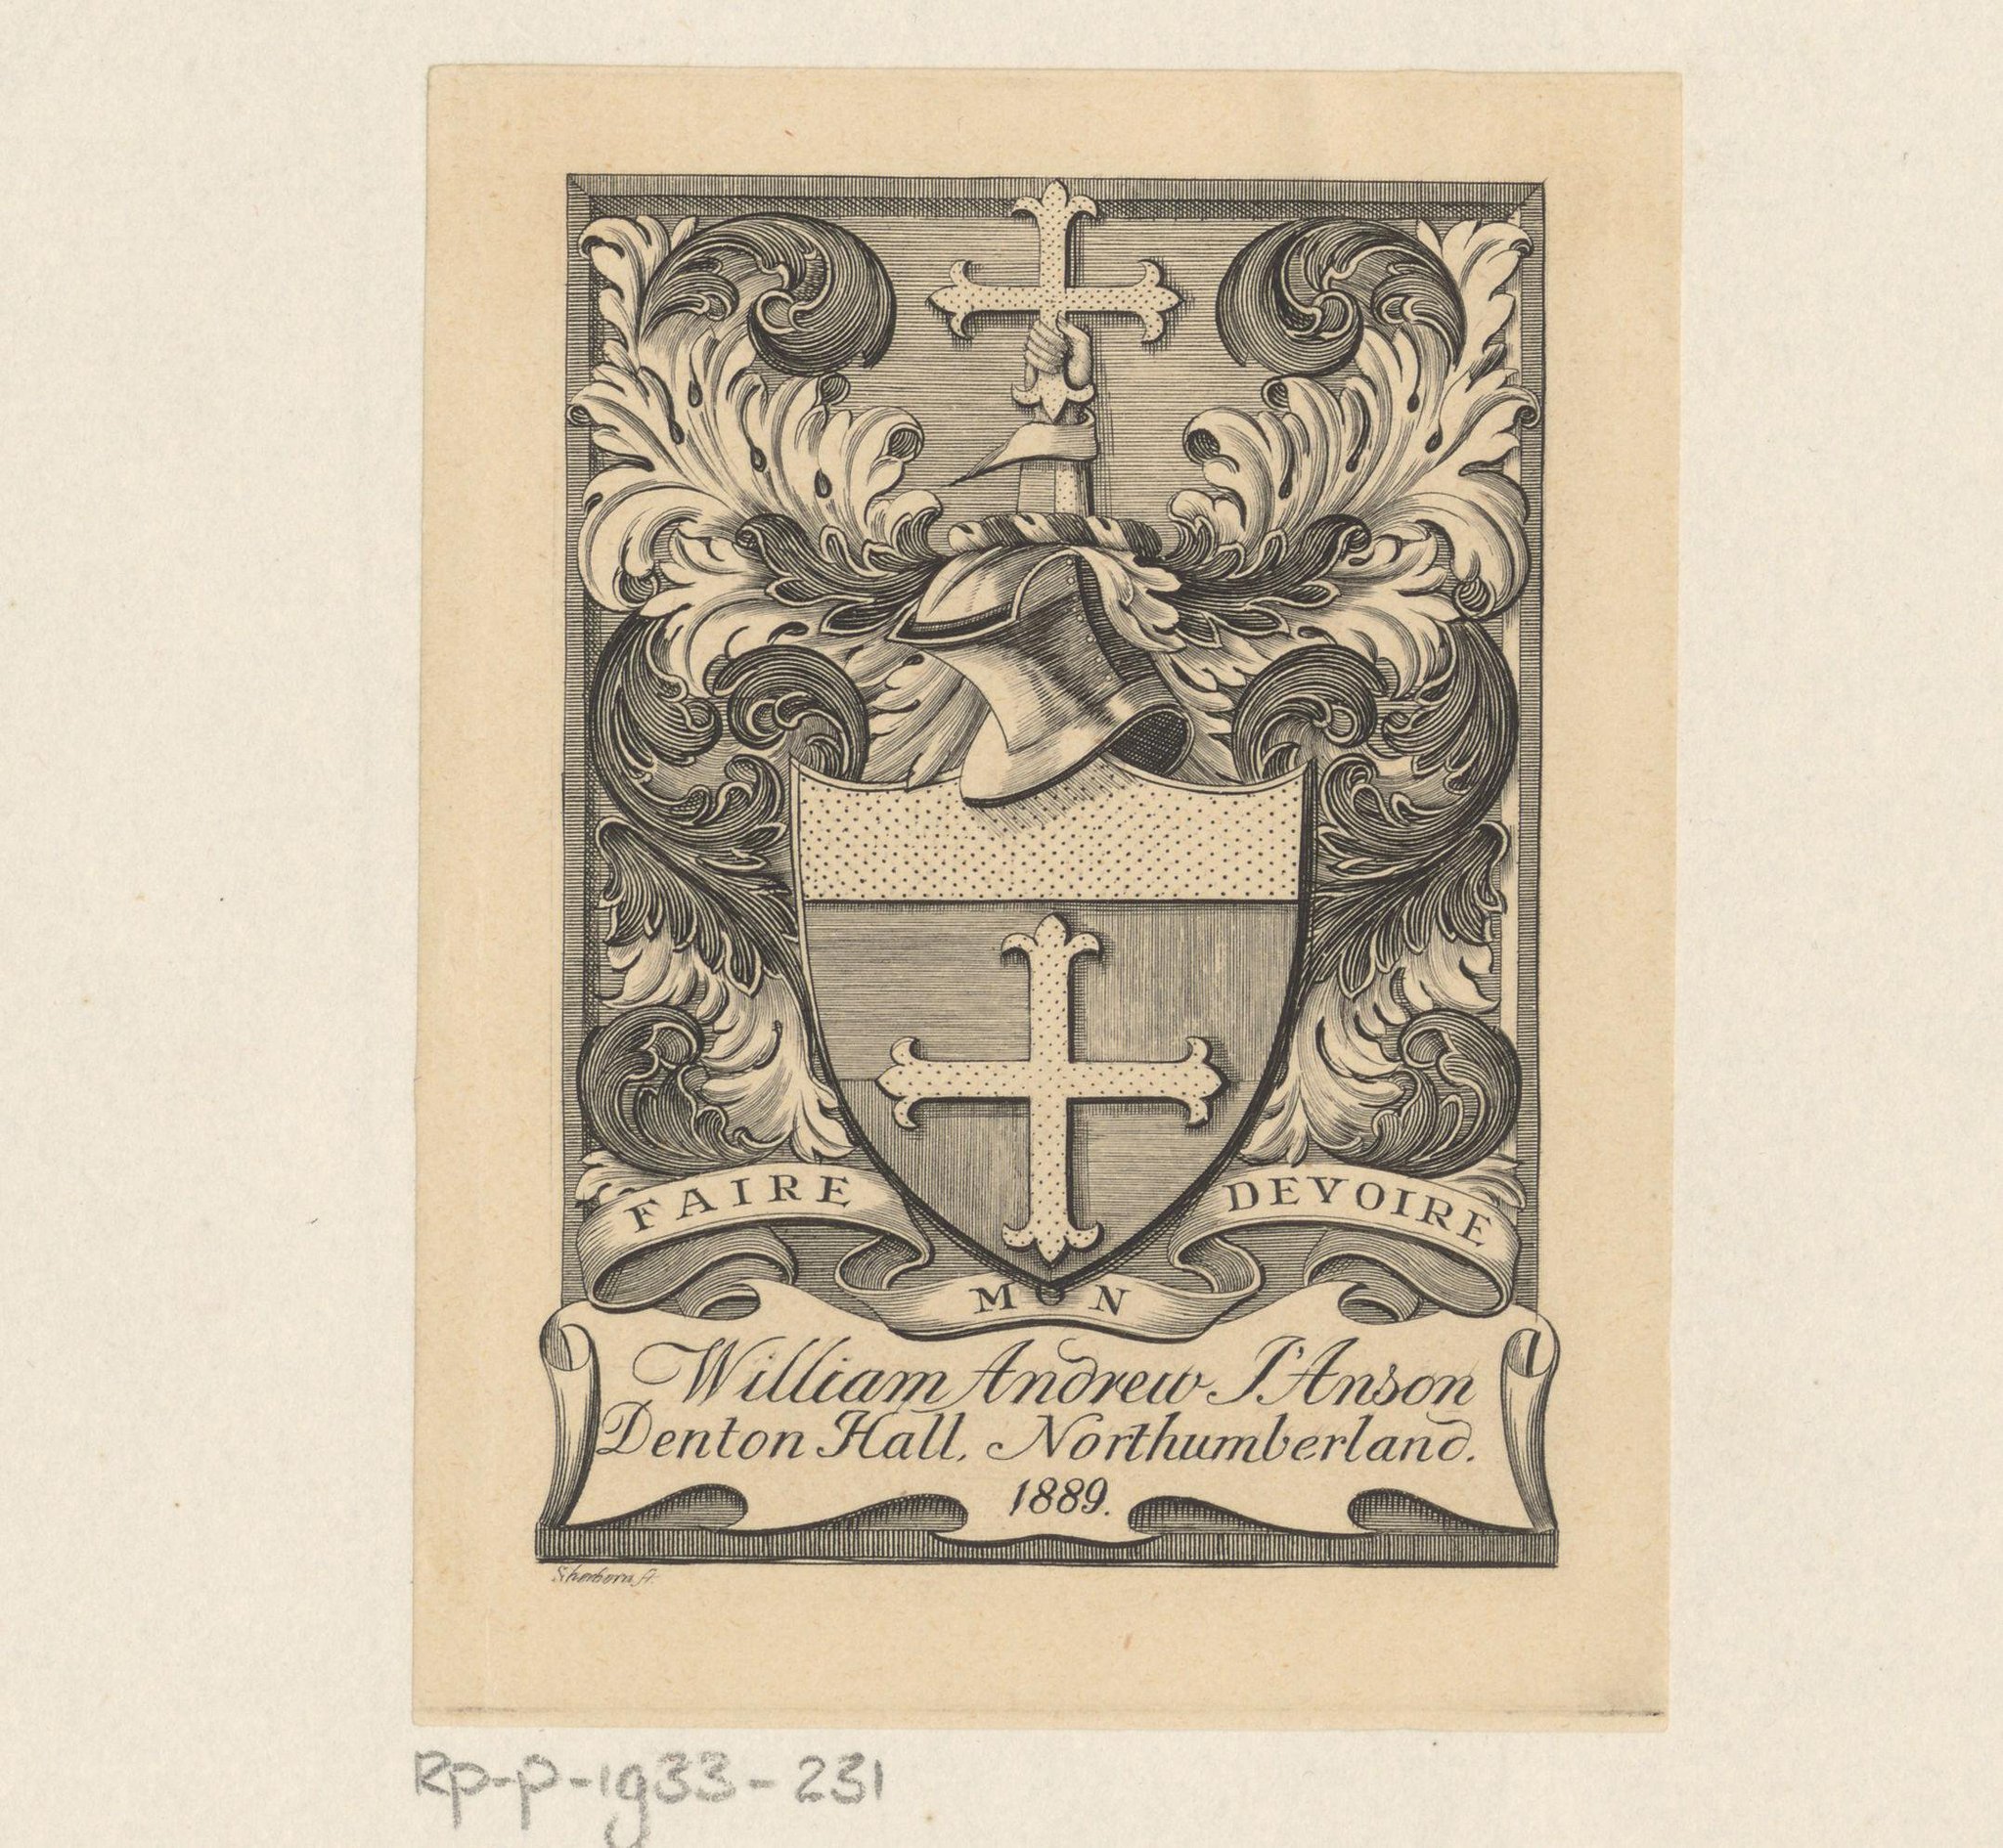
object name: bookplate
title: Faire mon devoire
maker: charles william sherborn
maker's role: print maker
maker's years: 1831-1912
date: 1889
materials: paper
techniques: engraving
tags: armorial bearing, heraldry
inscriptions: collector's mark: Lugt 2760